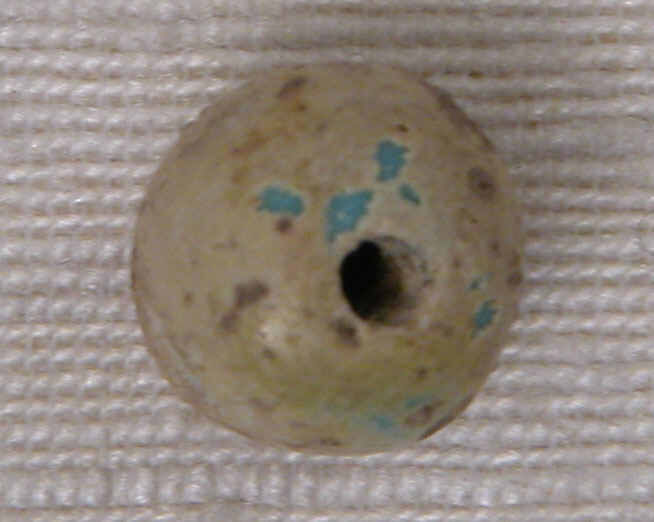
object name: bead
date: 701-1300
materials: ceramic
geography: iran